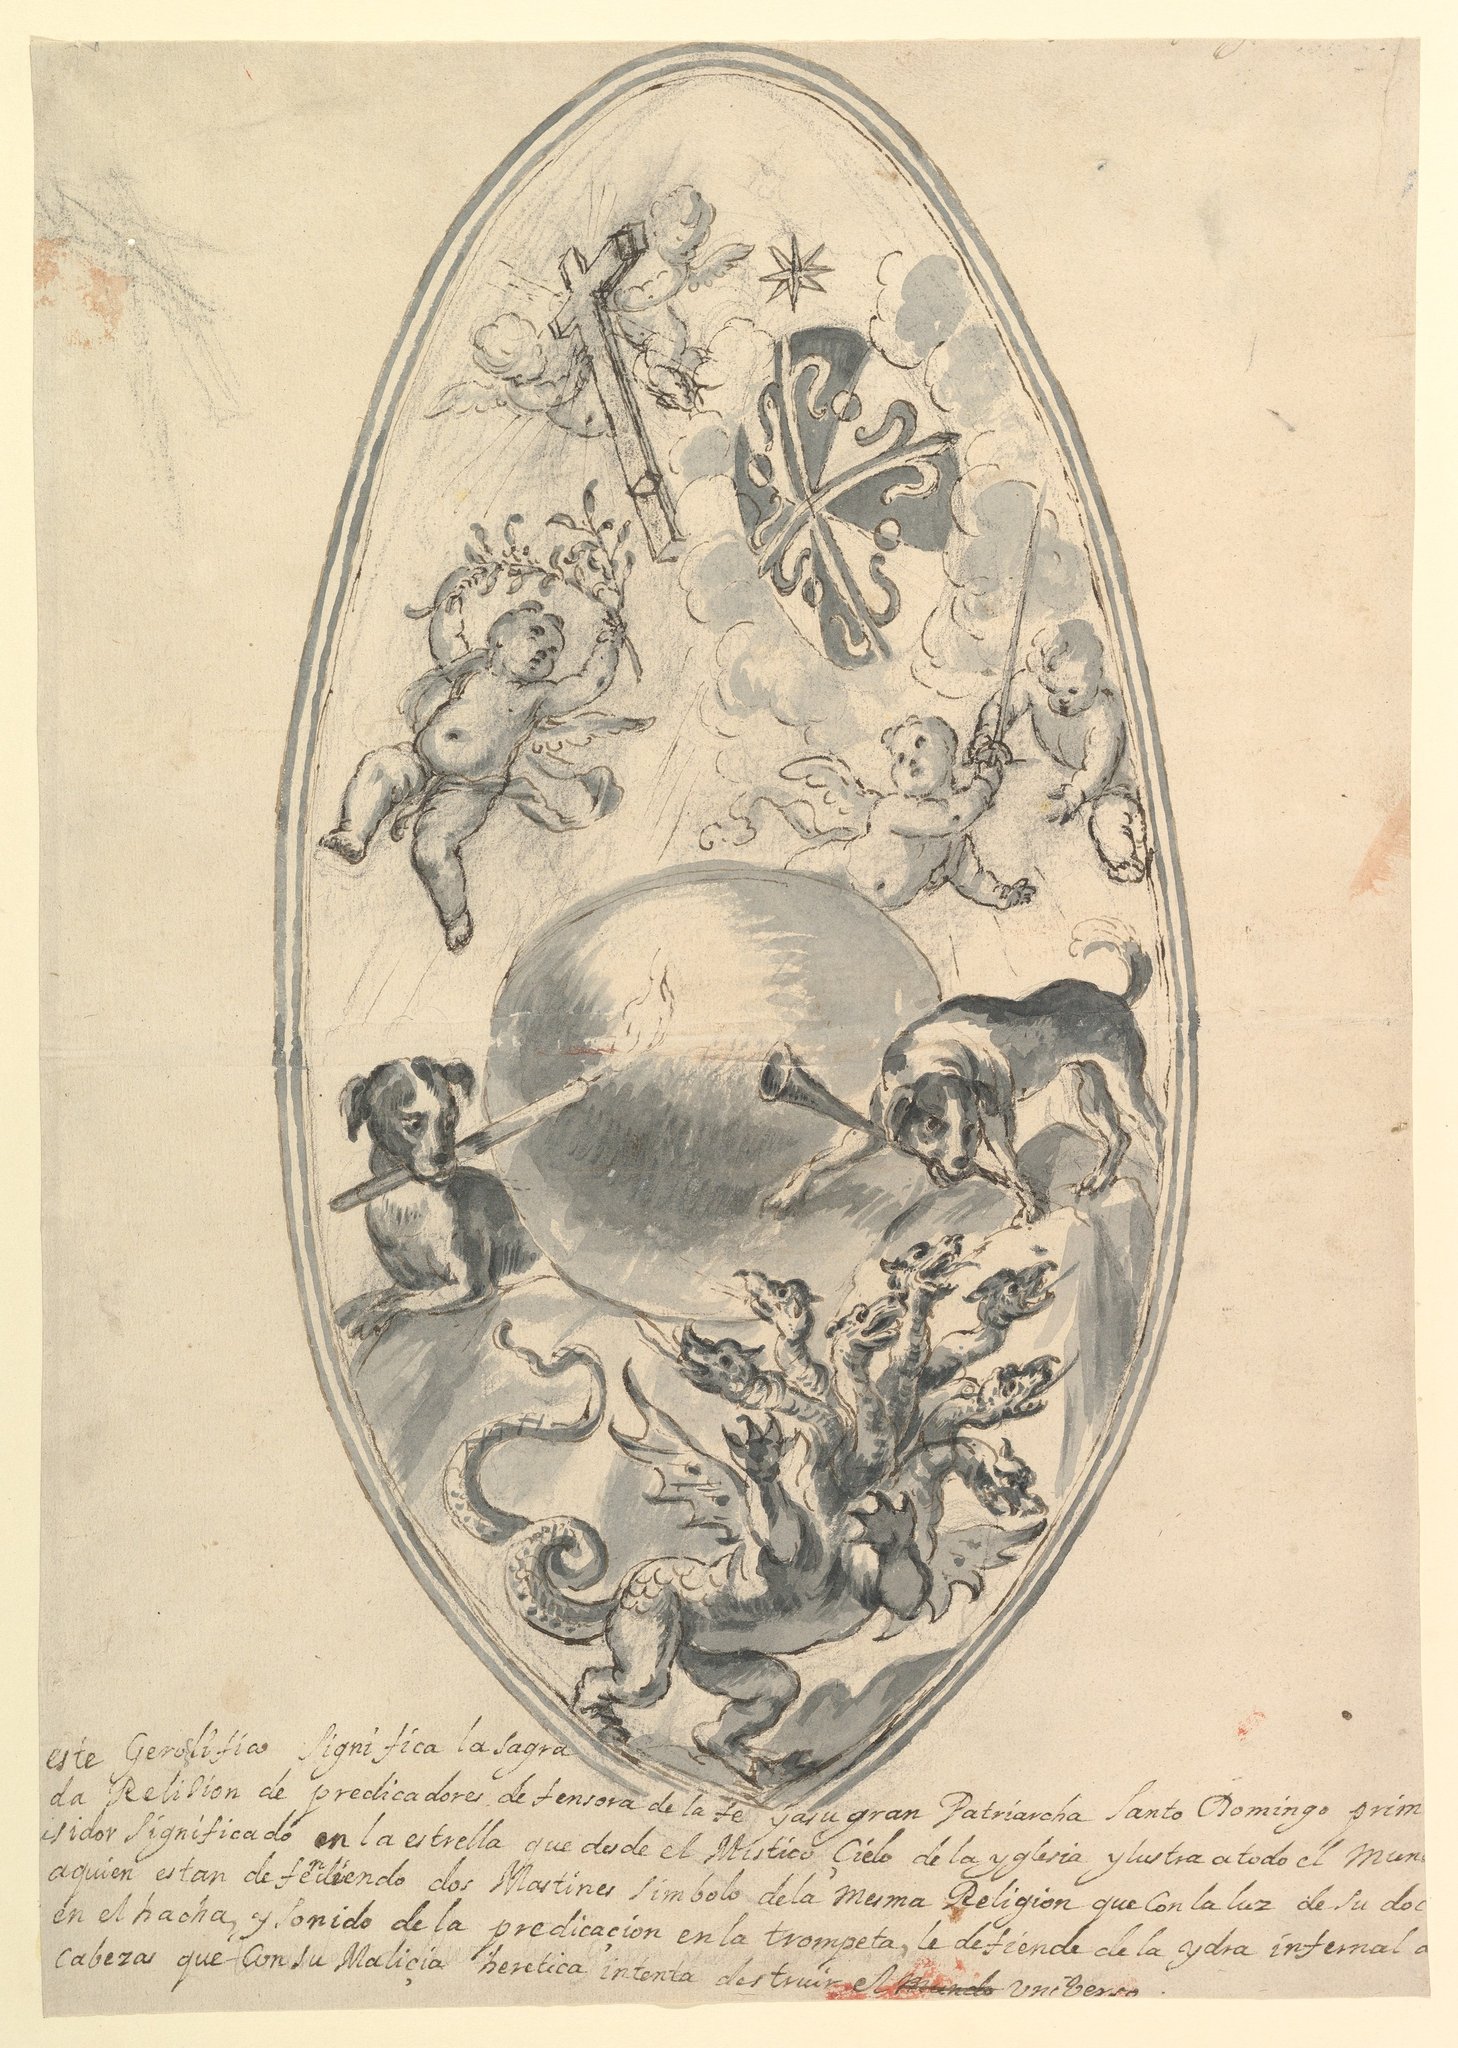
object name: drawing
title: Allegory of Heaven and Hell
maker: claudio coello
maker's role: artist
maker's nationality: spanish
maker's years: 1642-1693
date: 1642-1693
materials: chalk, ink, paper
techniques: brush, pen, drawing, wash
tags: swords,dogs,cross